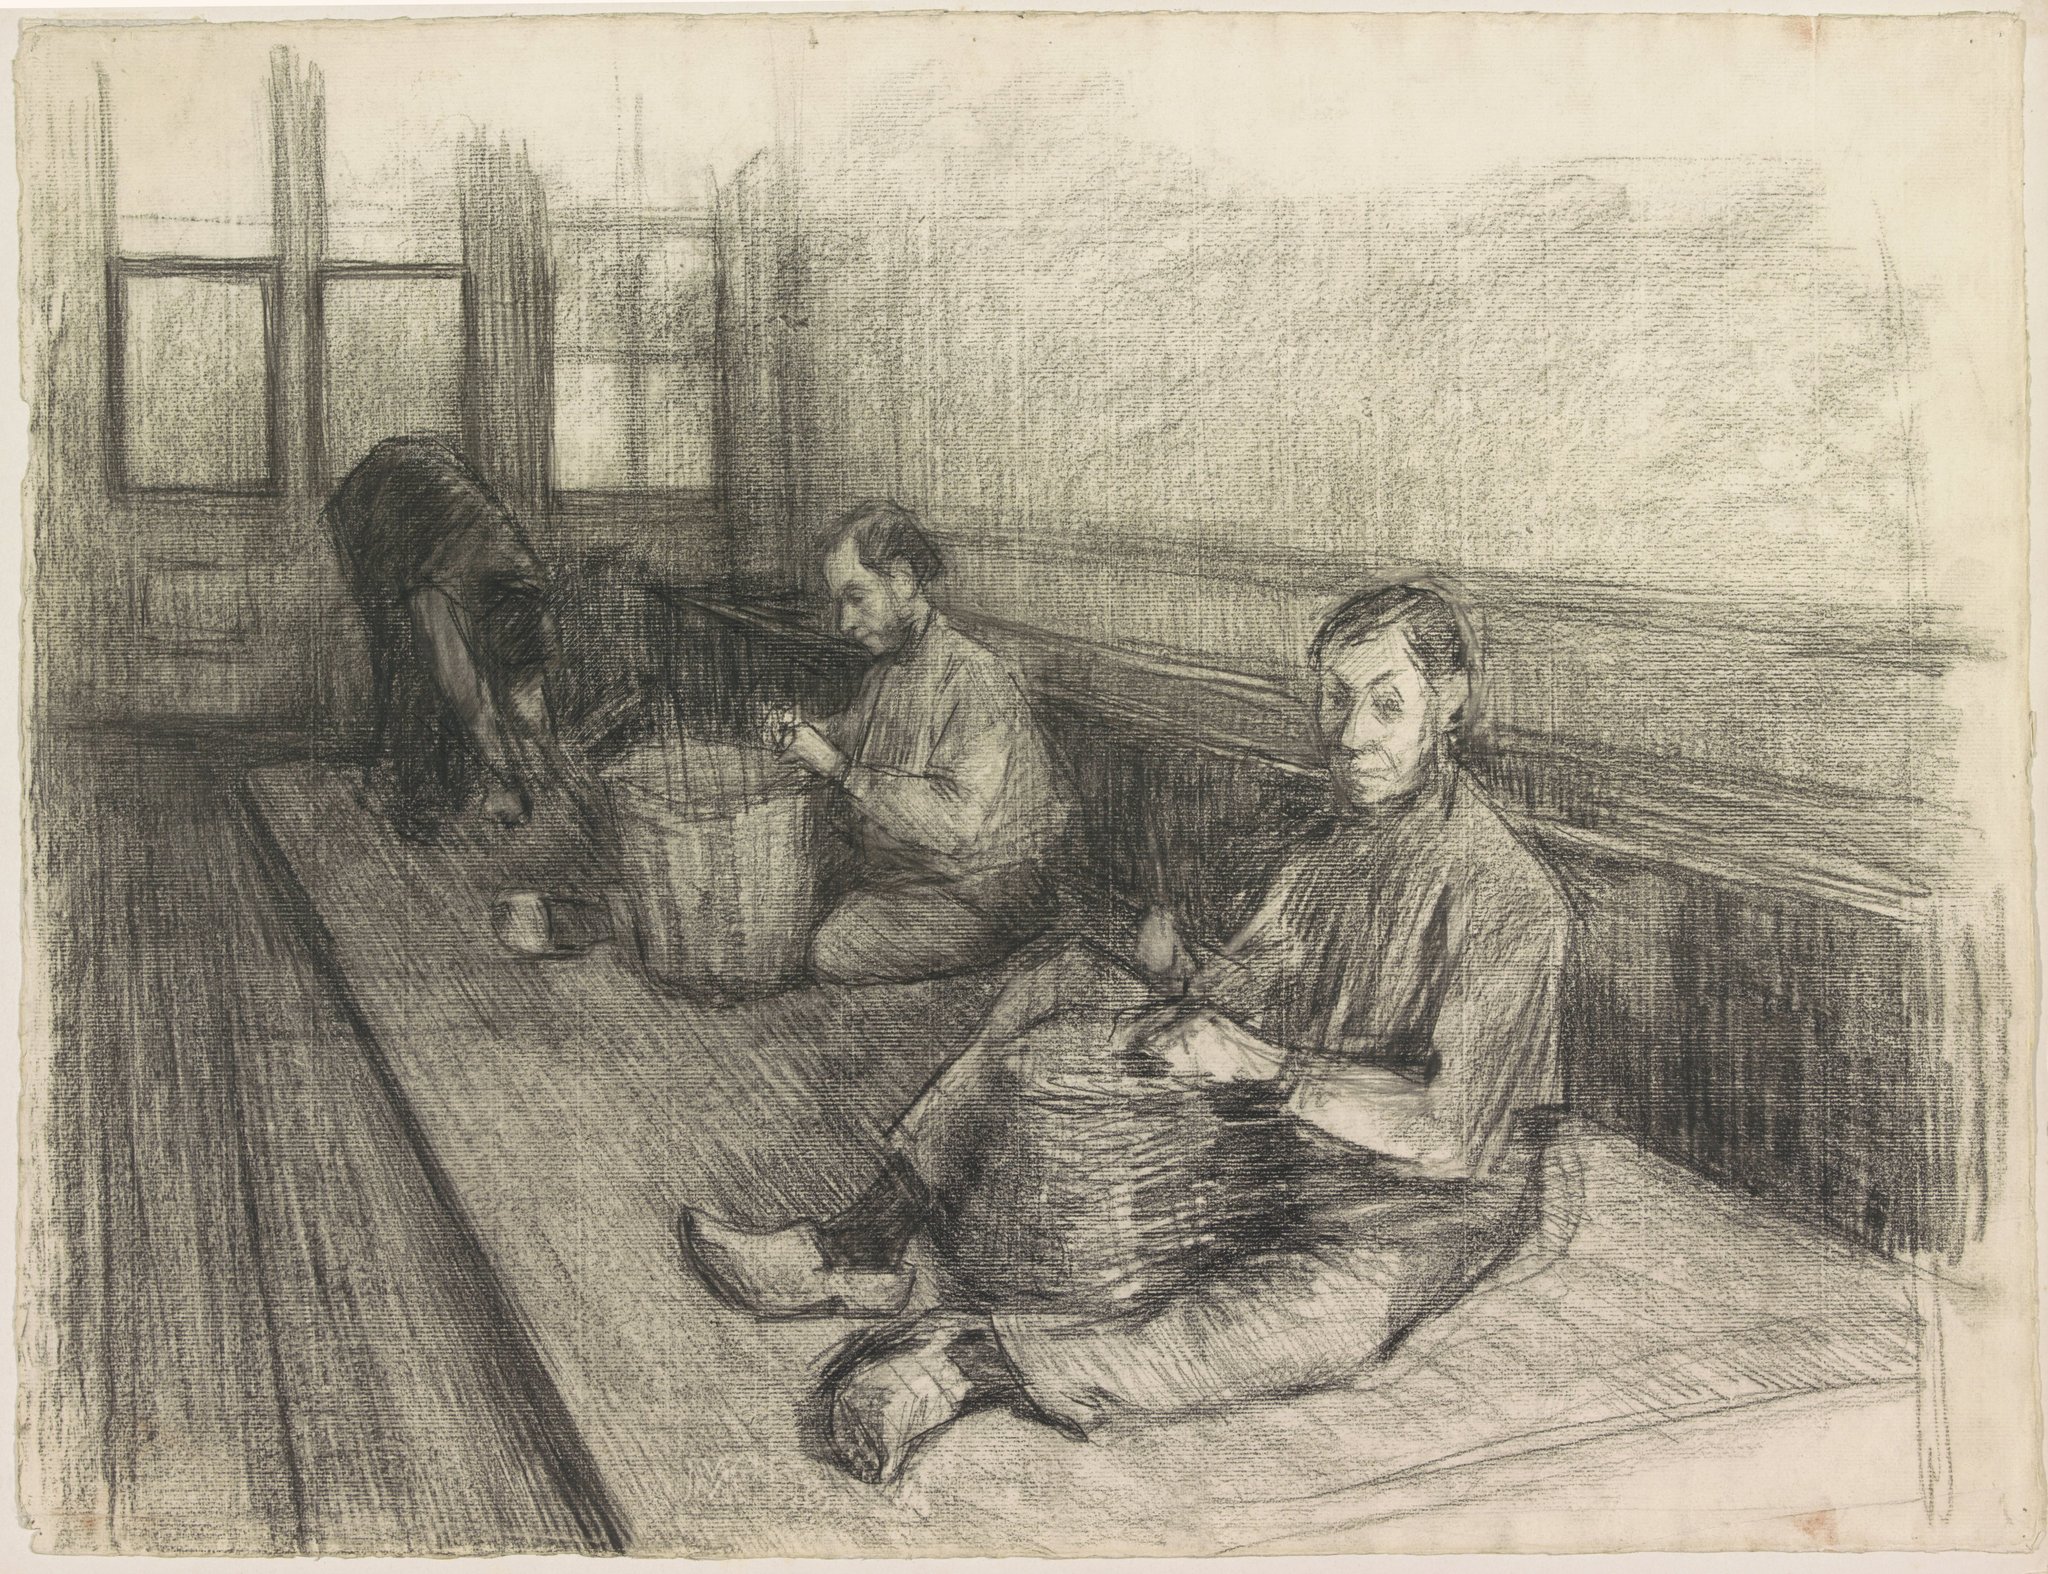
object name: drawing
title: Blinde mandenmakers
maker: anthon gerhard alexander van rappard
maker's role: draughtsman, print maker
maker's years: 1858-1892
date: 1868-1892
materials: charcoal, paper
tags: handicrafts ~ other plant material, blind, blindness, container made of plant material other than wood: basket